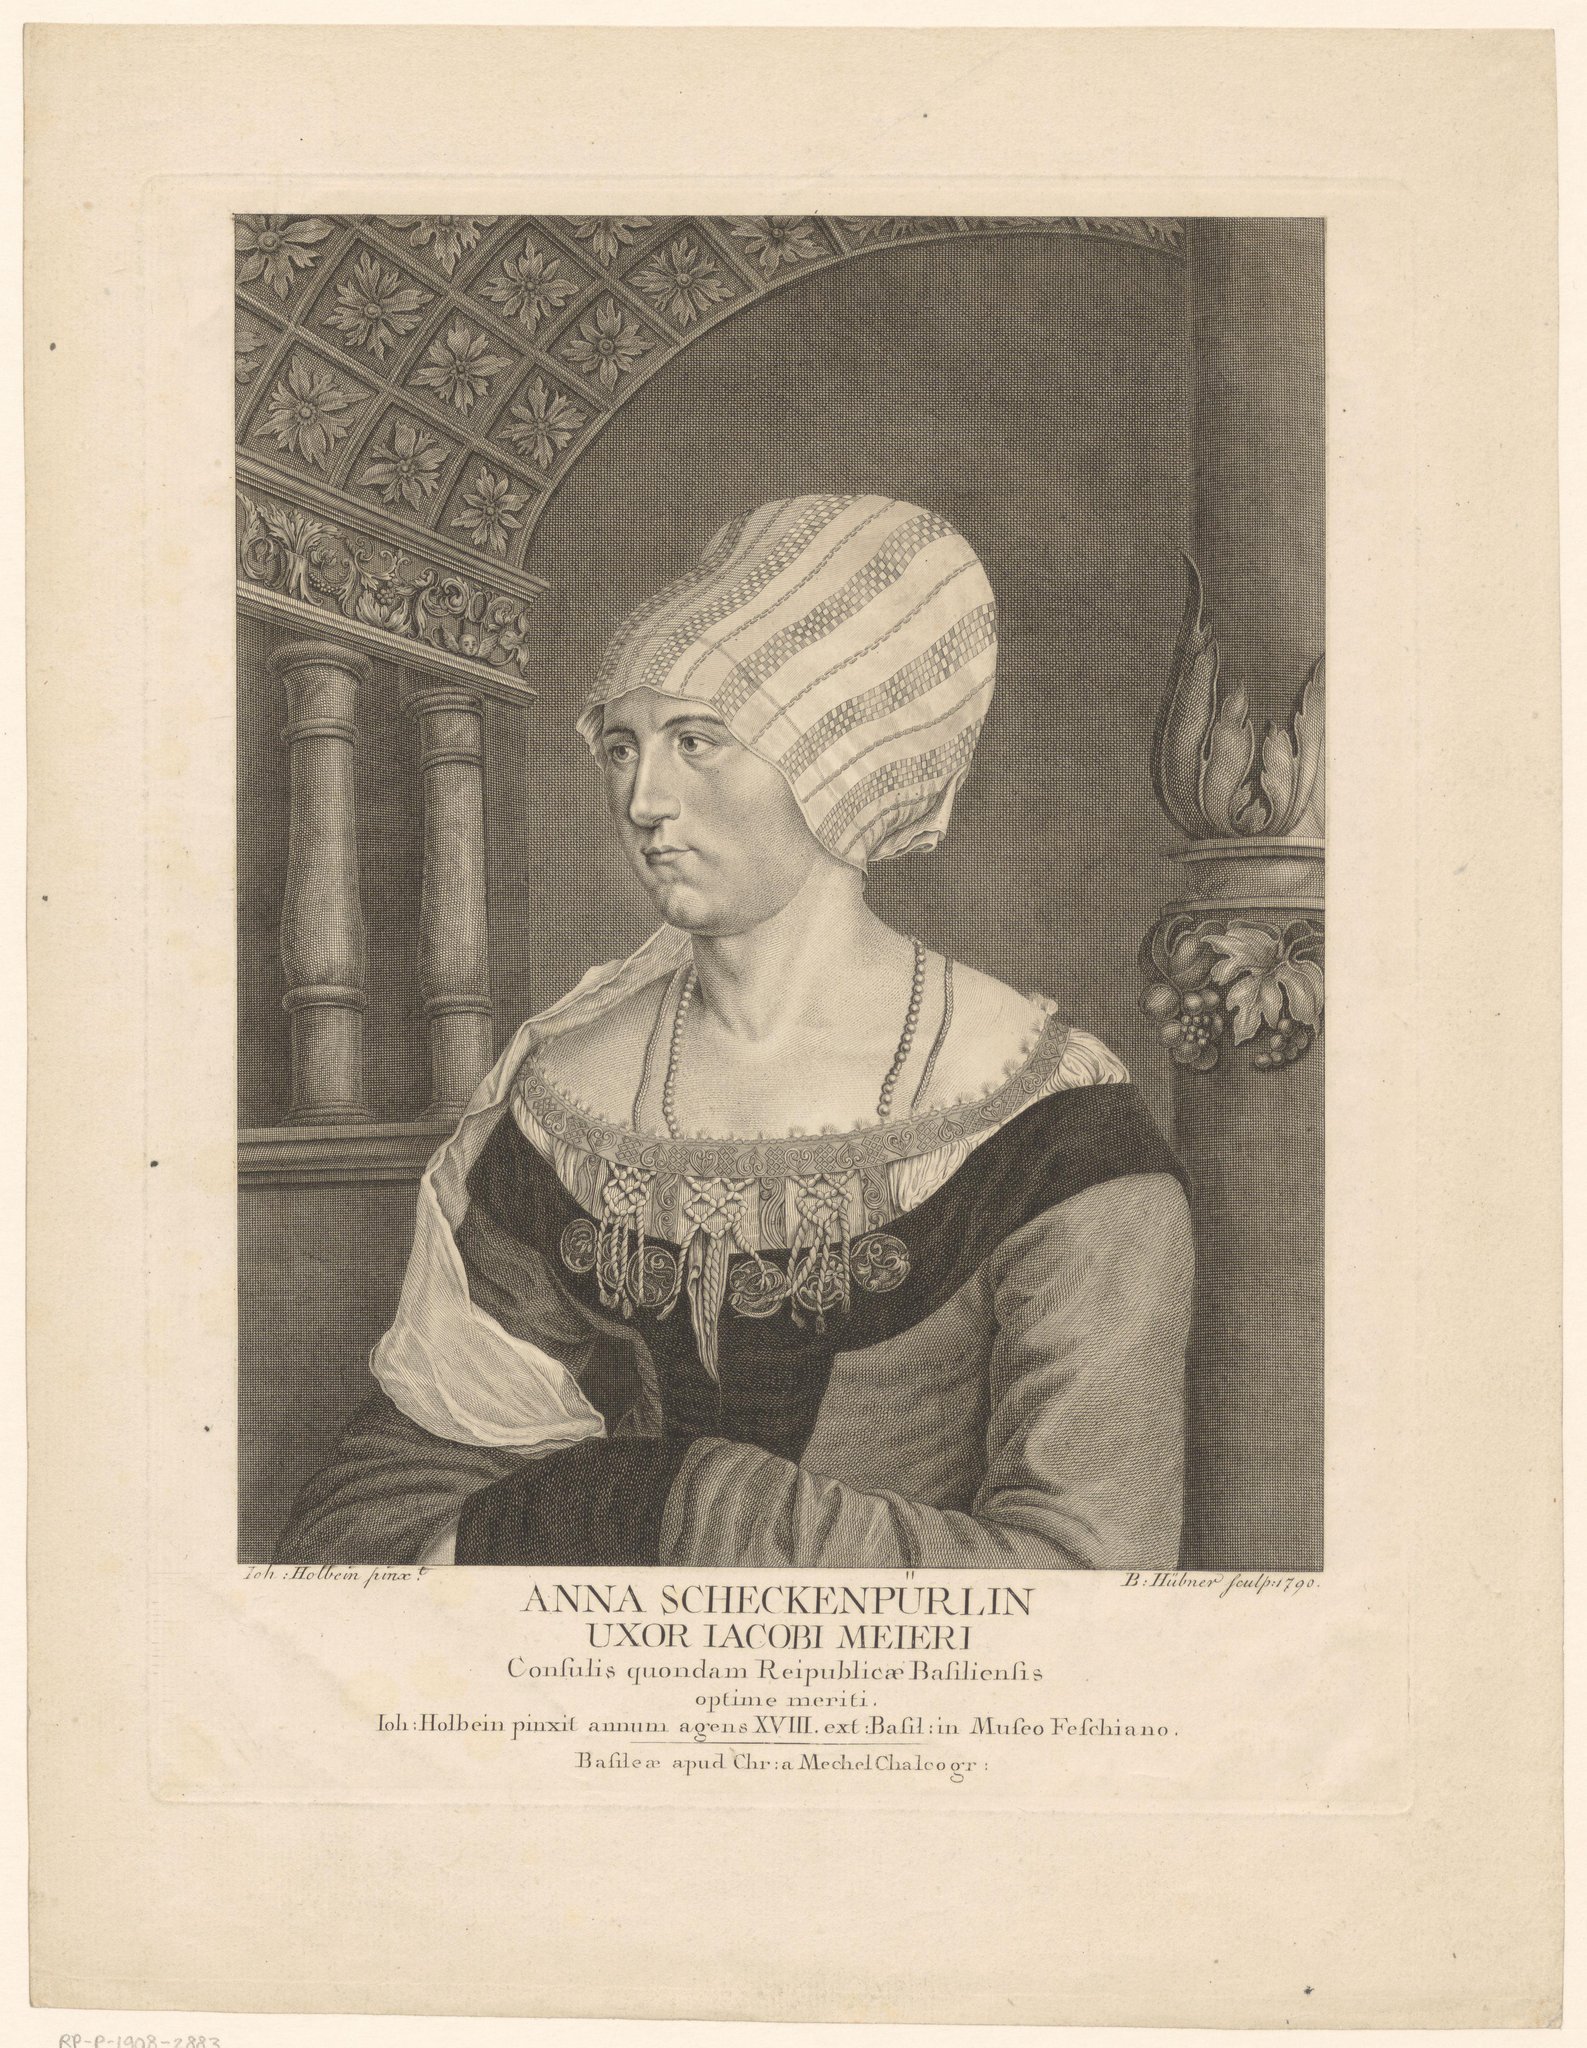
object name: print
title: Portret van Dorothea Kannengiesser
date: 1790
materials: paper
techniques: engraving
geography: basel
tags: historical persons, ornament derived from architectural details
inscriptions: collector's mark: Lugt 2228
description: Deze prent is gemaakt naar een schilderij door Hans Holbein de Jongere van Dorothea Kannengiesser (het rechter pendant van een dubbelportret met haar echtgenoot Jacob Meyer zum Hasen) uit 1516, dat zich in de Faesch collectie van het Kunstmuseum Basel bevindt onder inv. nr. 312.